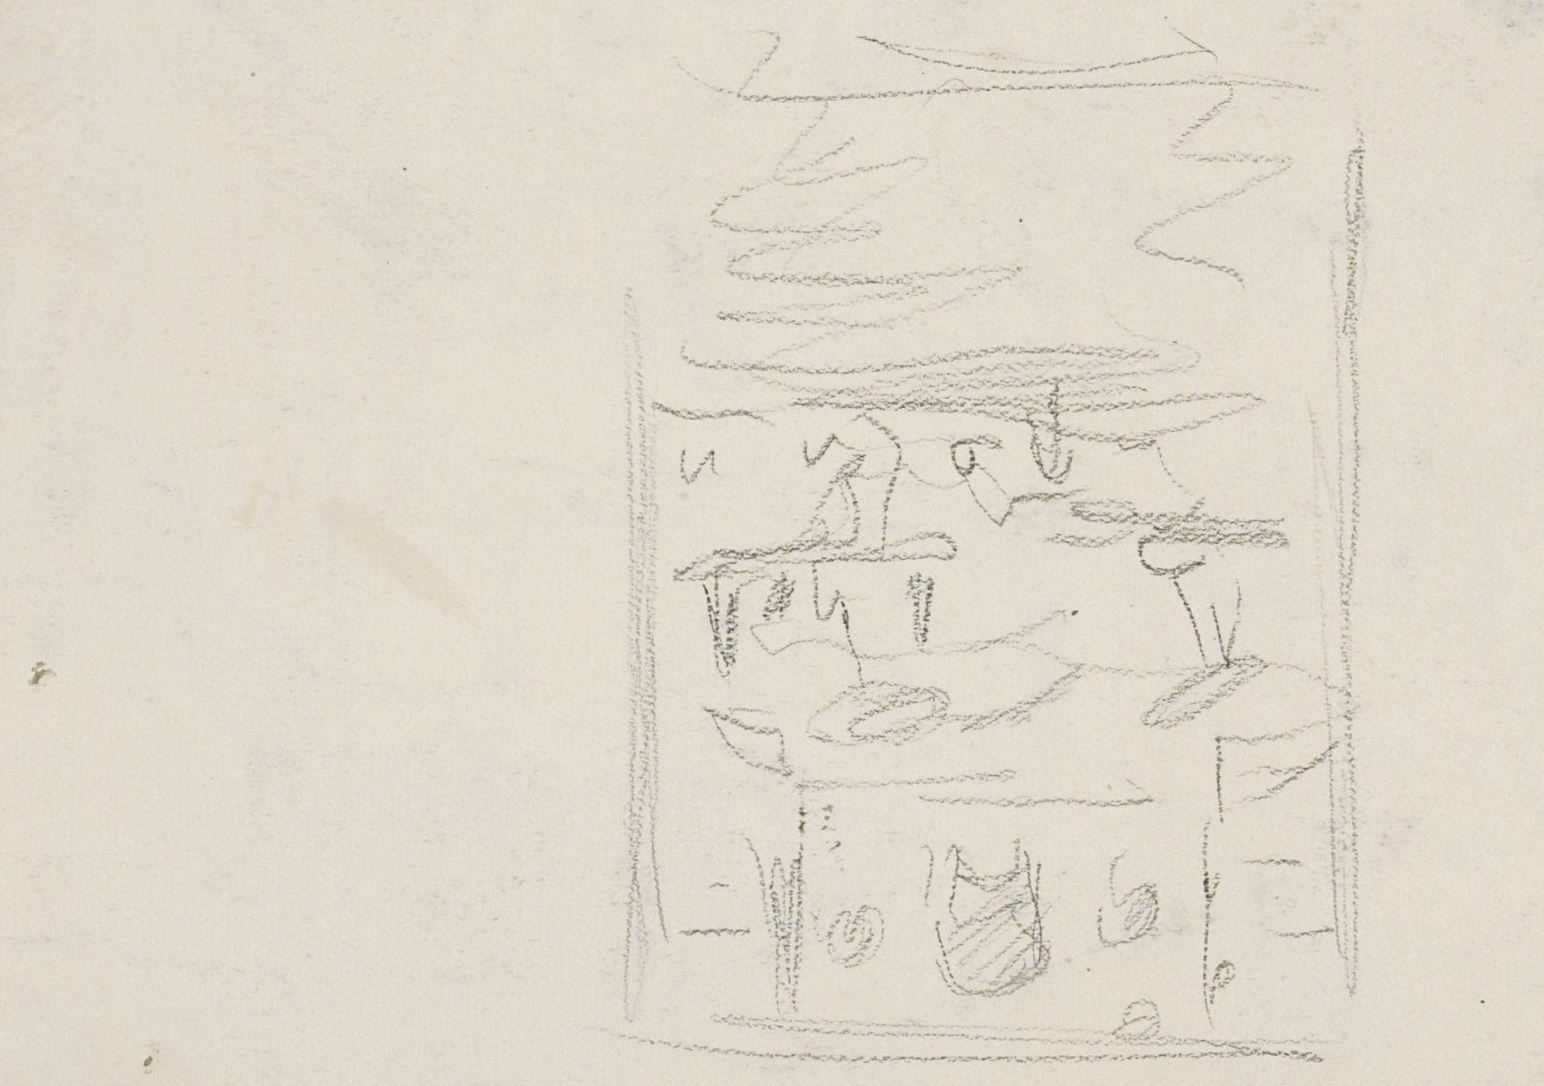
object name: sketchbook leaf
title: Boten met parasols op de Ganges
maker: marius bauer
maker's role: draughtsman, print maker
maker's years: 1867-1932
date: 1924-1925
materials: chalk, paper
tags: river, rowing-boat, canoe, etc., parasol, sunshade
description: Pagina 41 uit een schetsboek met 23 bladen.